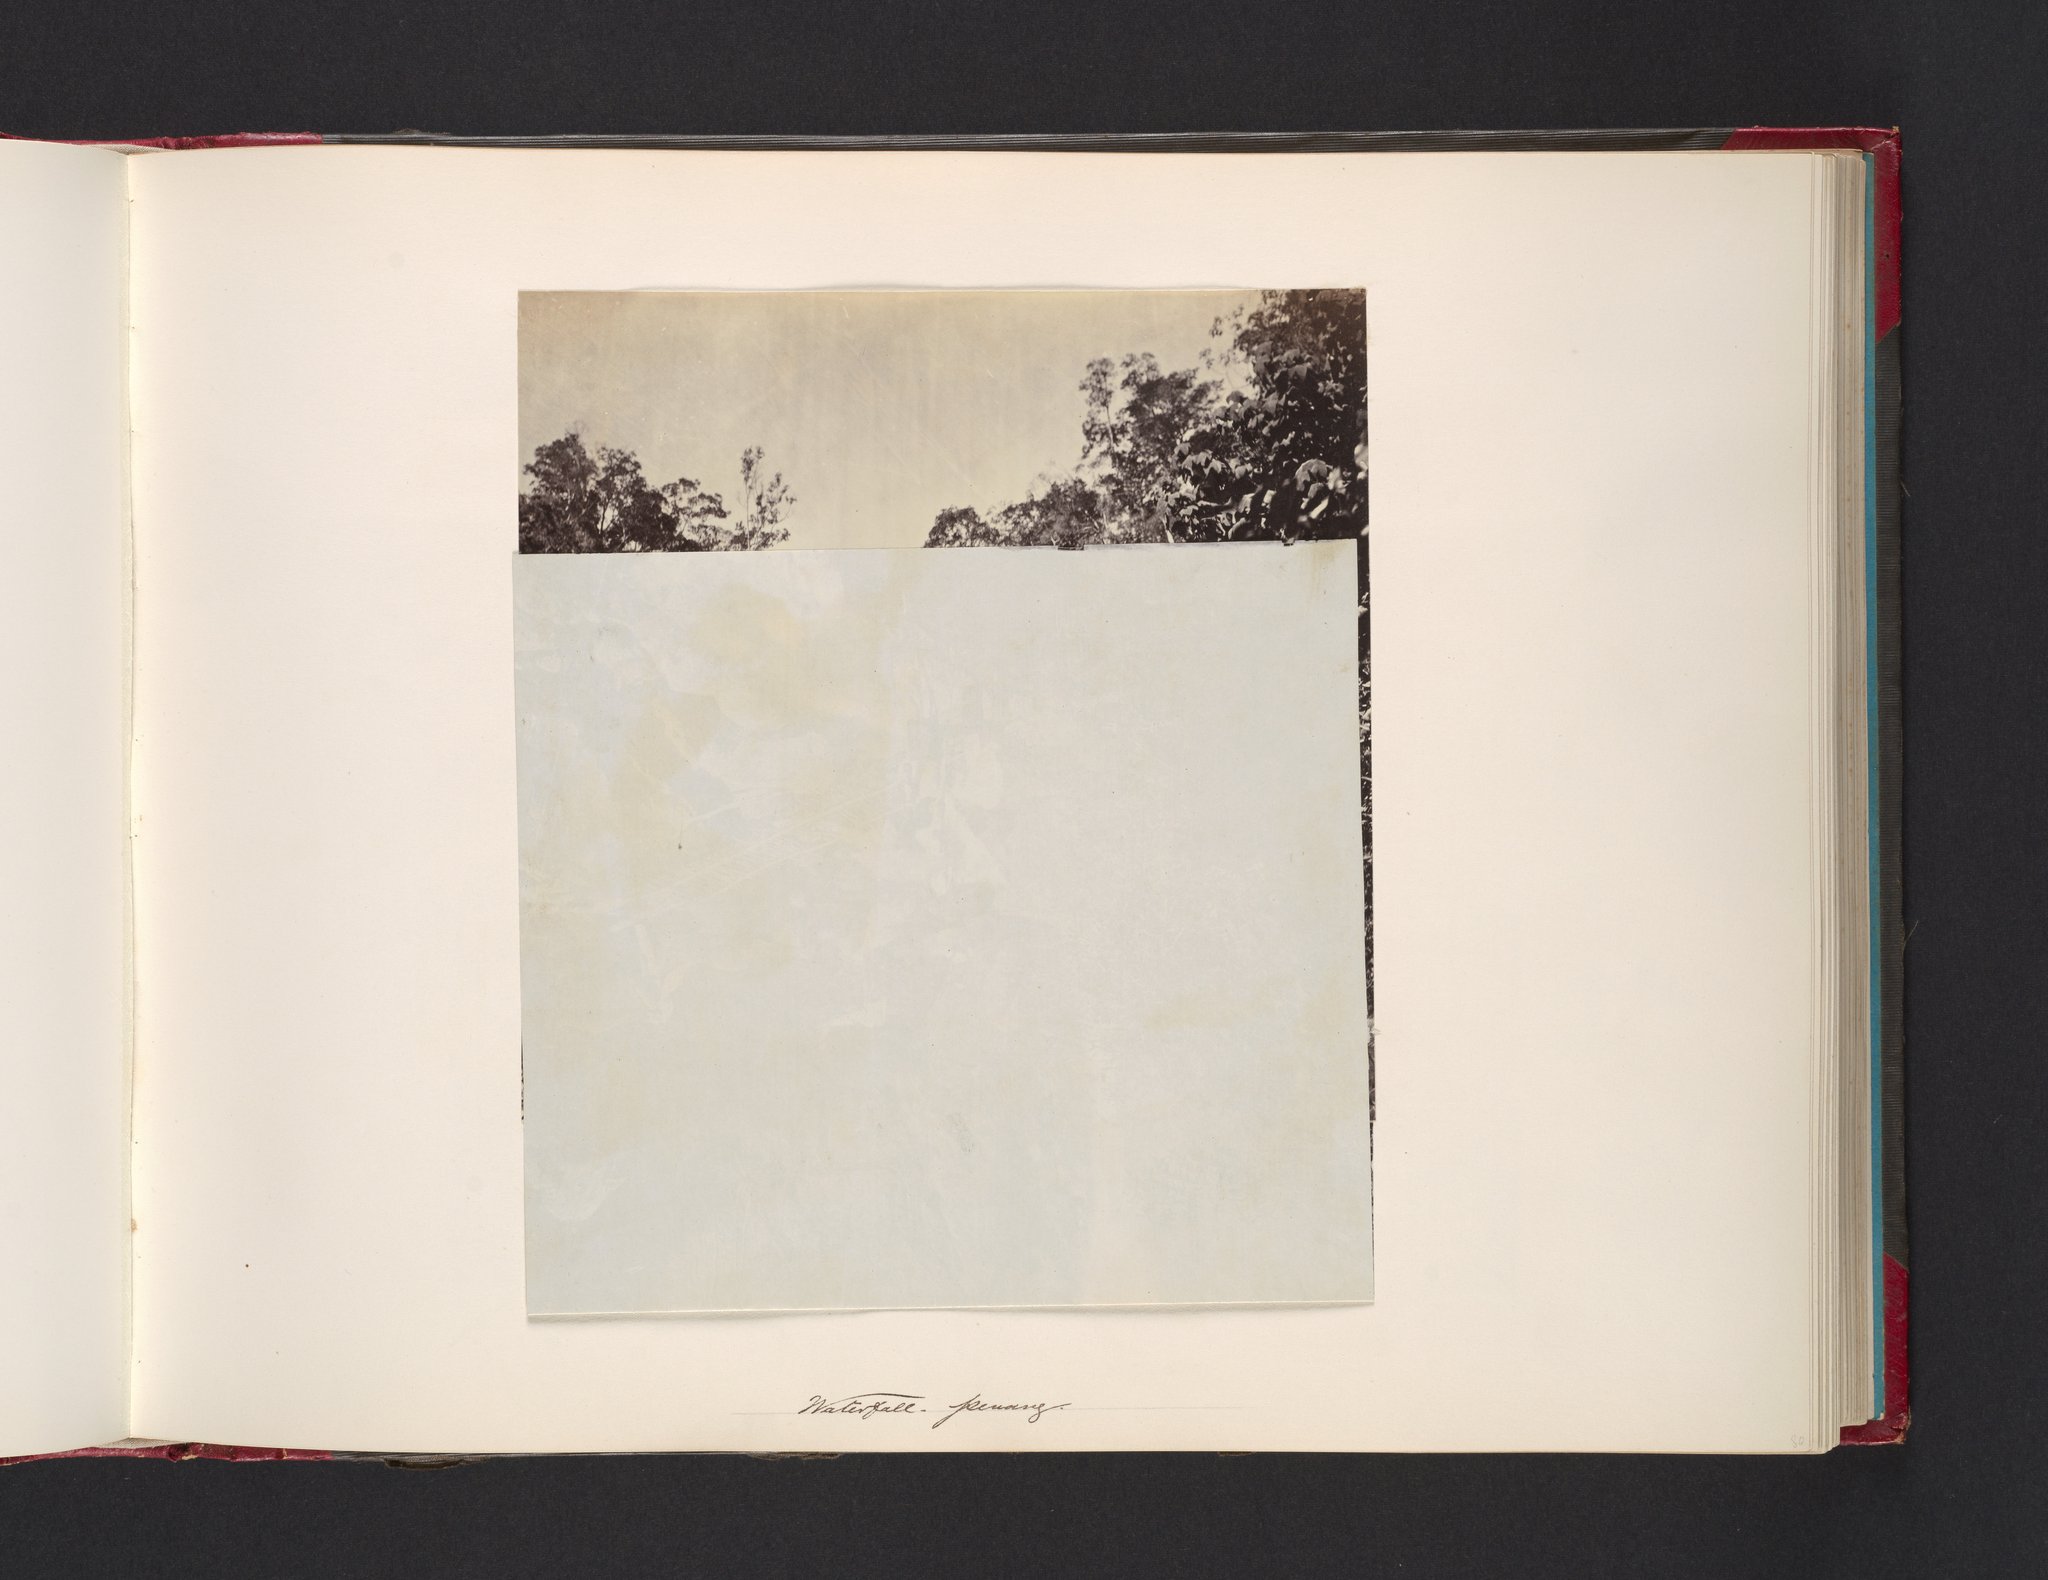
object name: photograph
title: Waterfall, Penang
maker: john thomson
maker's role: artist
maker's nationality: british, scottish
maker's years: 1837-1921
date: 1865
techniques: albumen silver print, glass negative